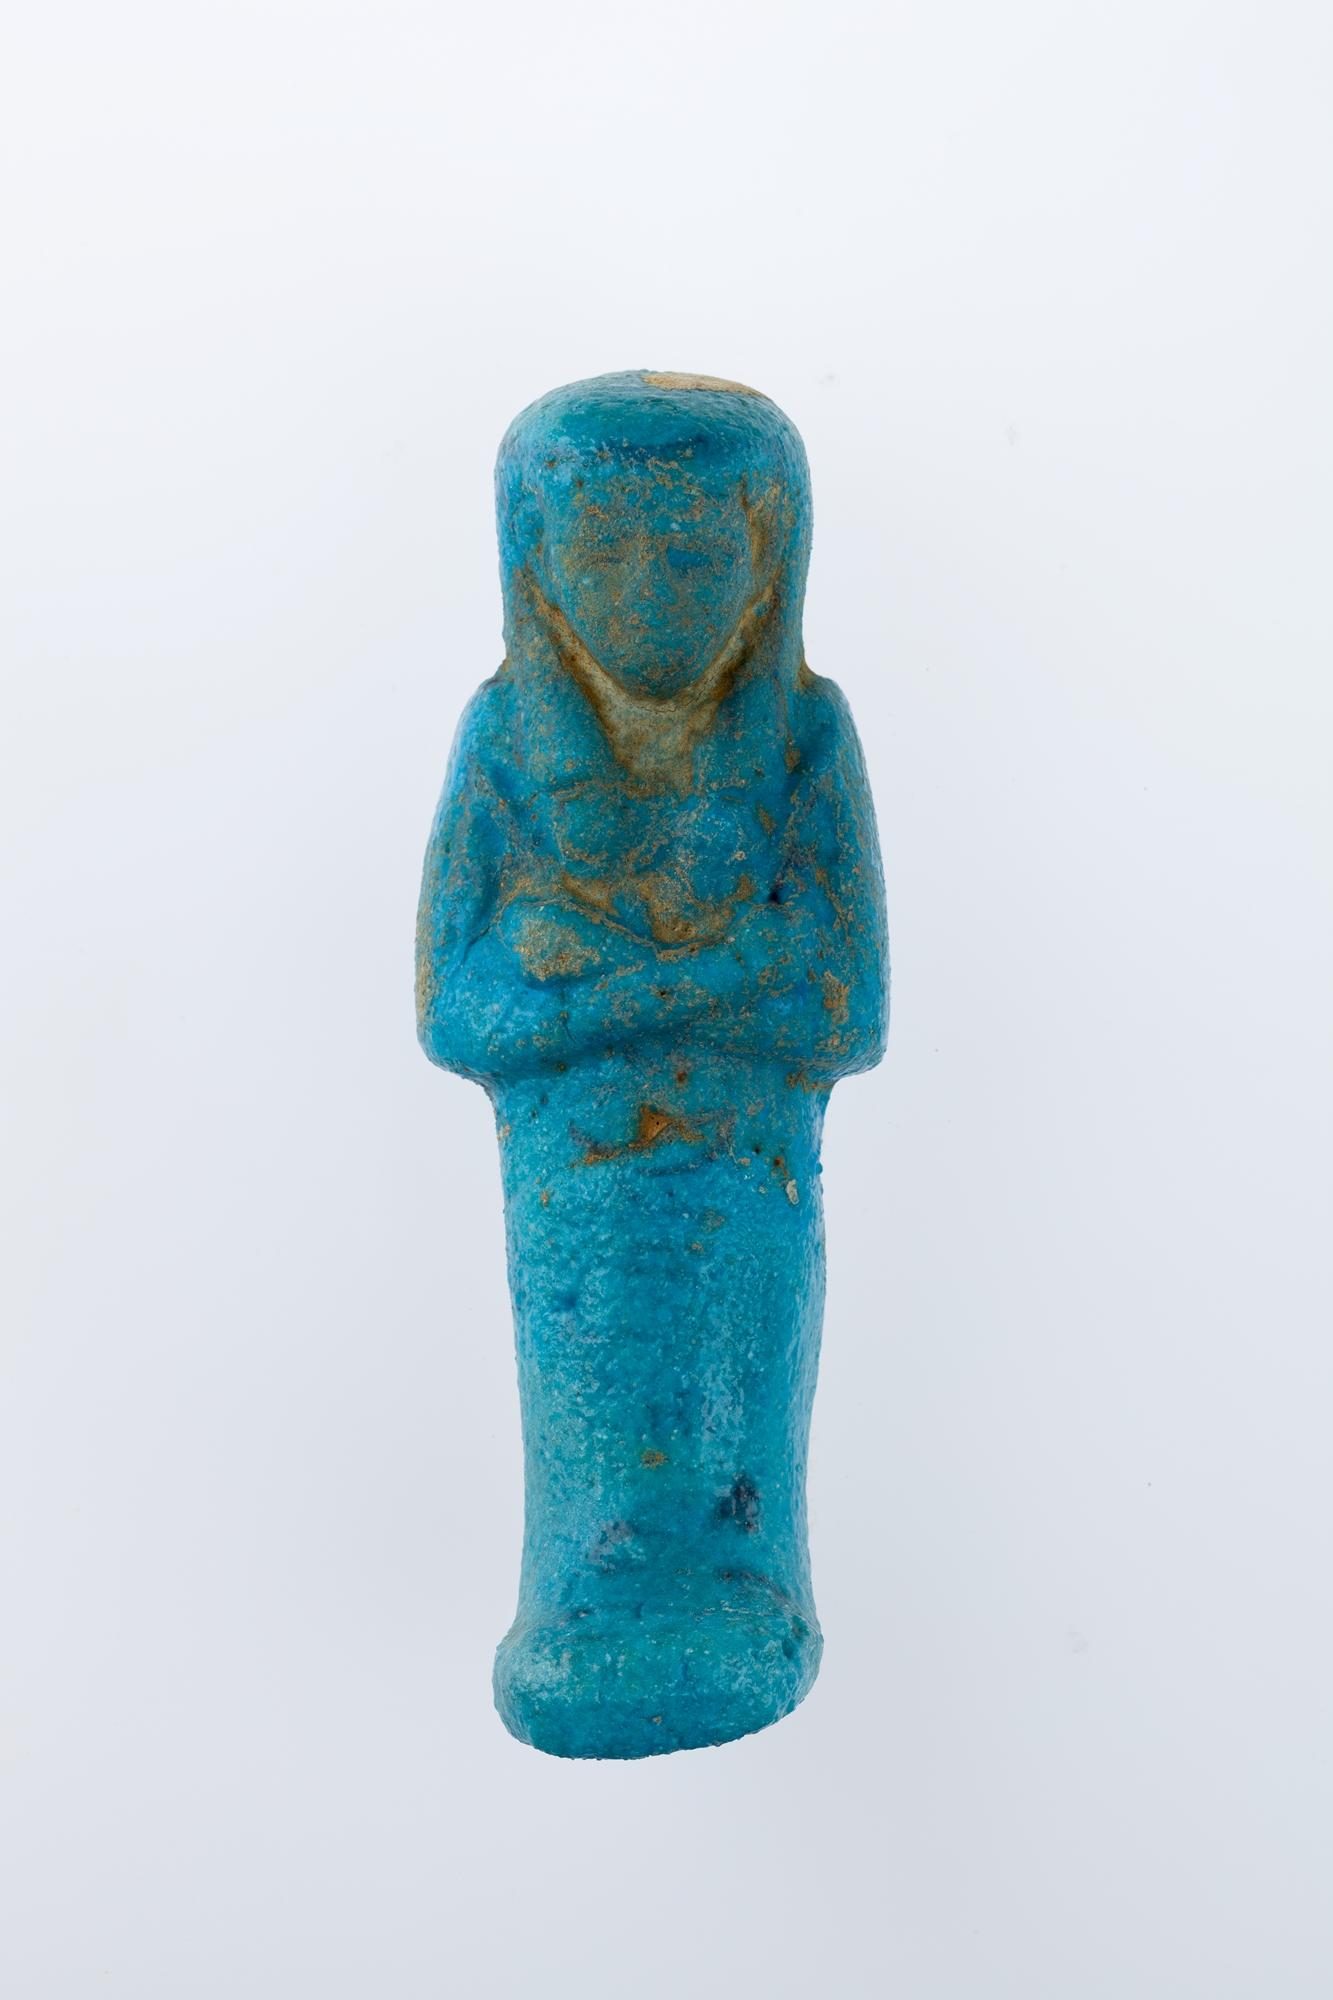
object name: shabti, henettawy c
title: Worker Shabti of Henettawy (C), Daughter of Isetemkheb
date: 990-970 BCE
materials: faience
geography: egypt